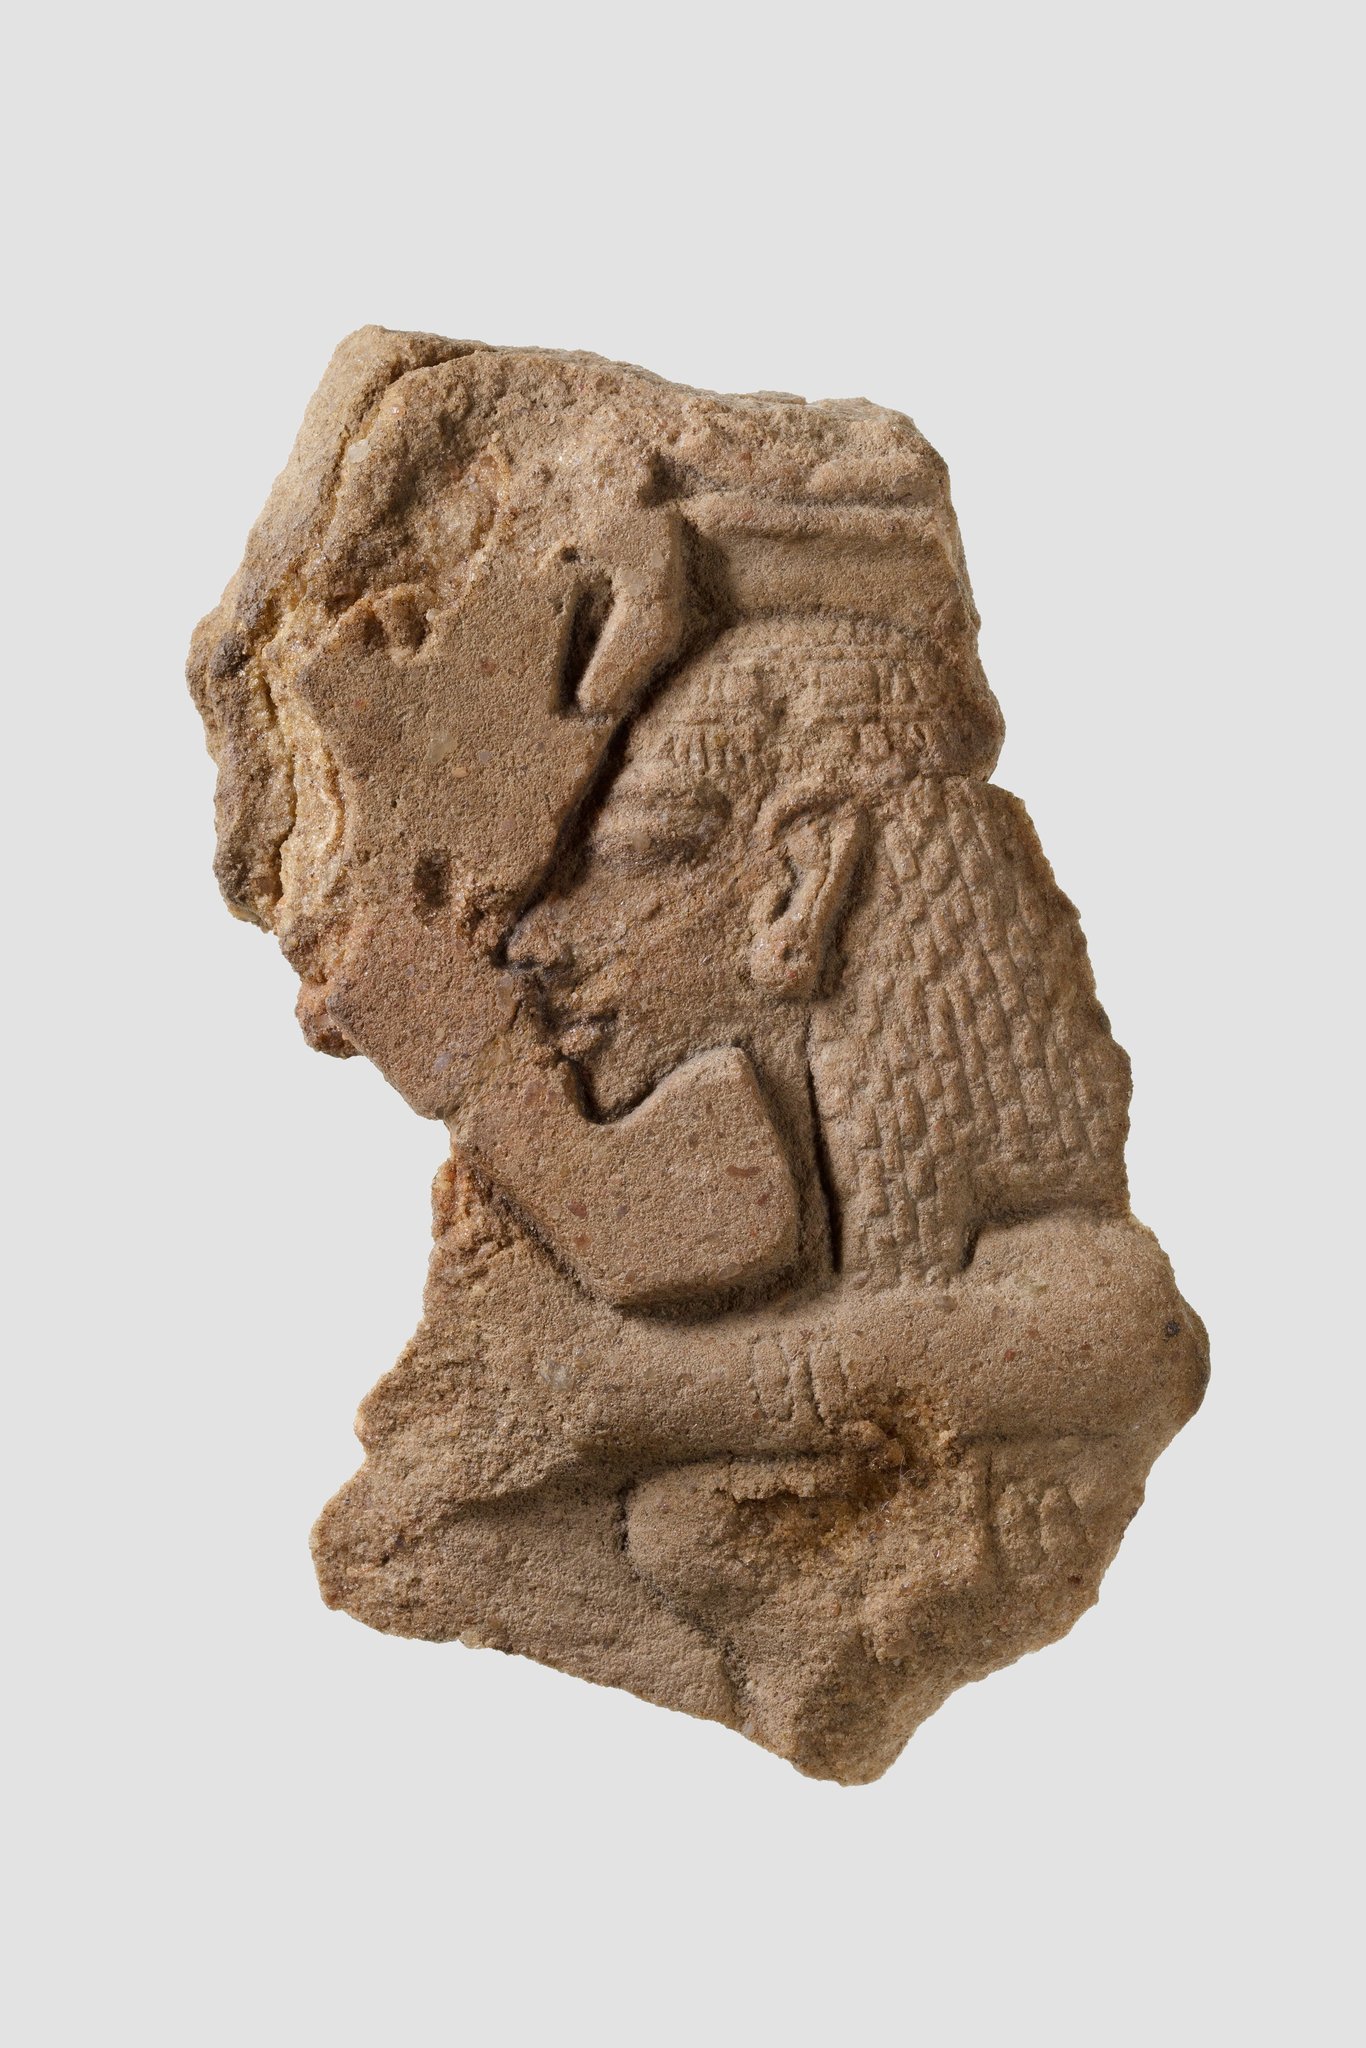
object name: relief, queen nefertiti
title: Relief of Queen Nefertiti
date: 1353-1336 BCE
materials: quartzite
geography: middle egypt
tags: nefertiti